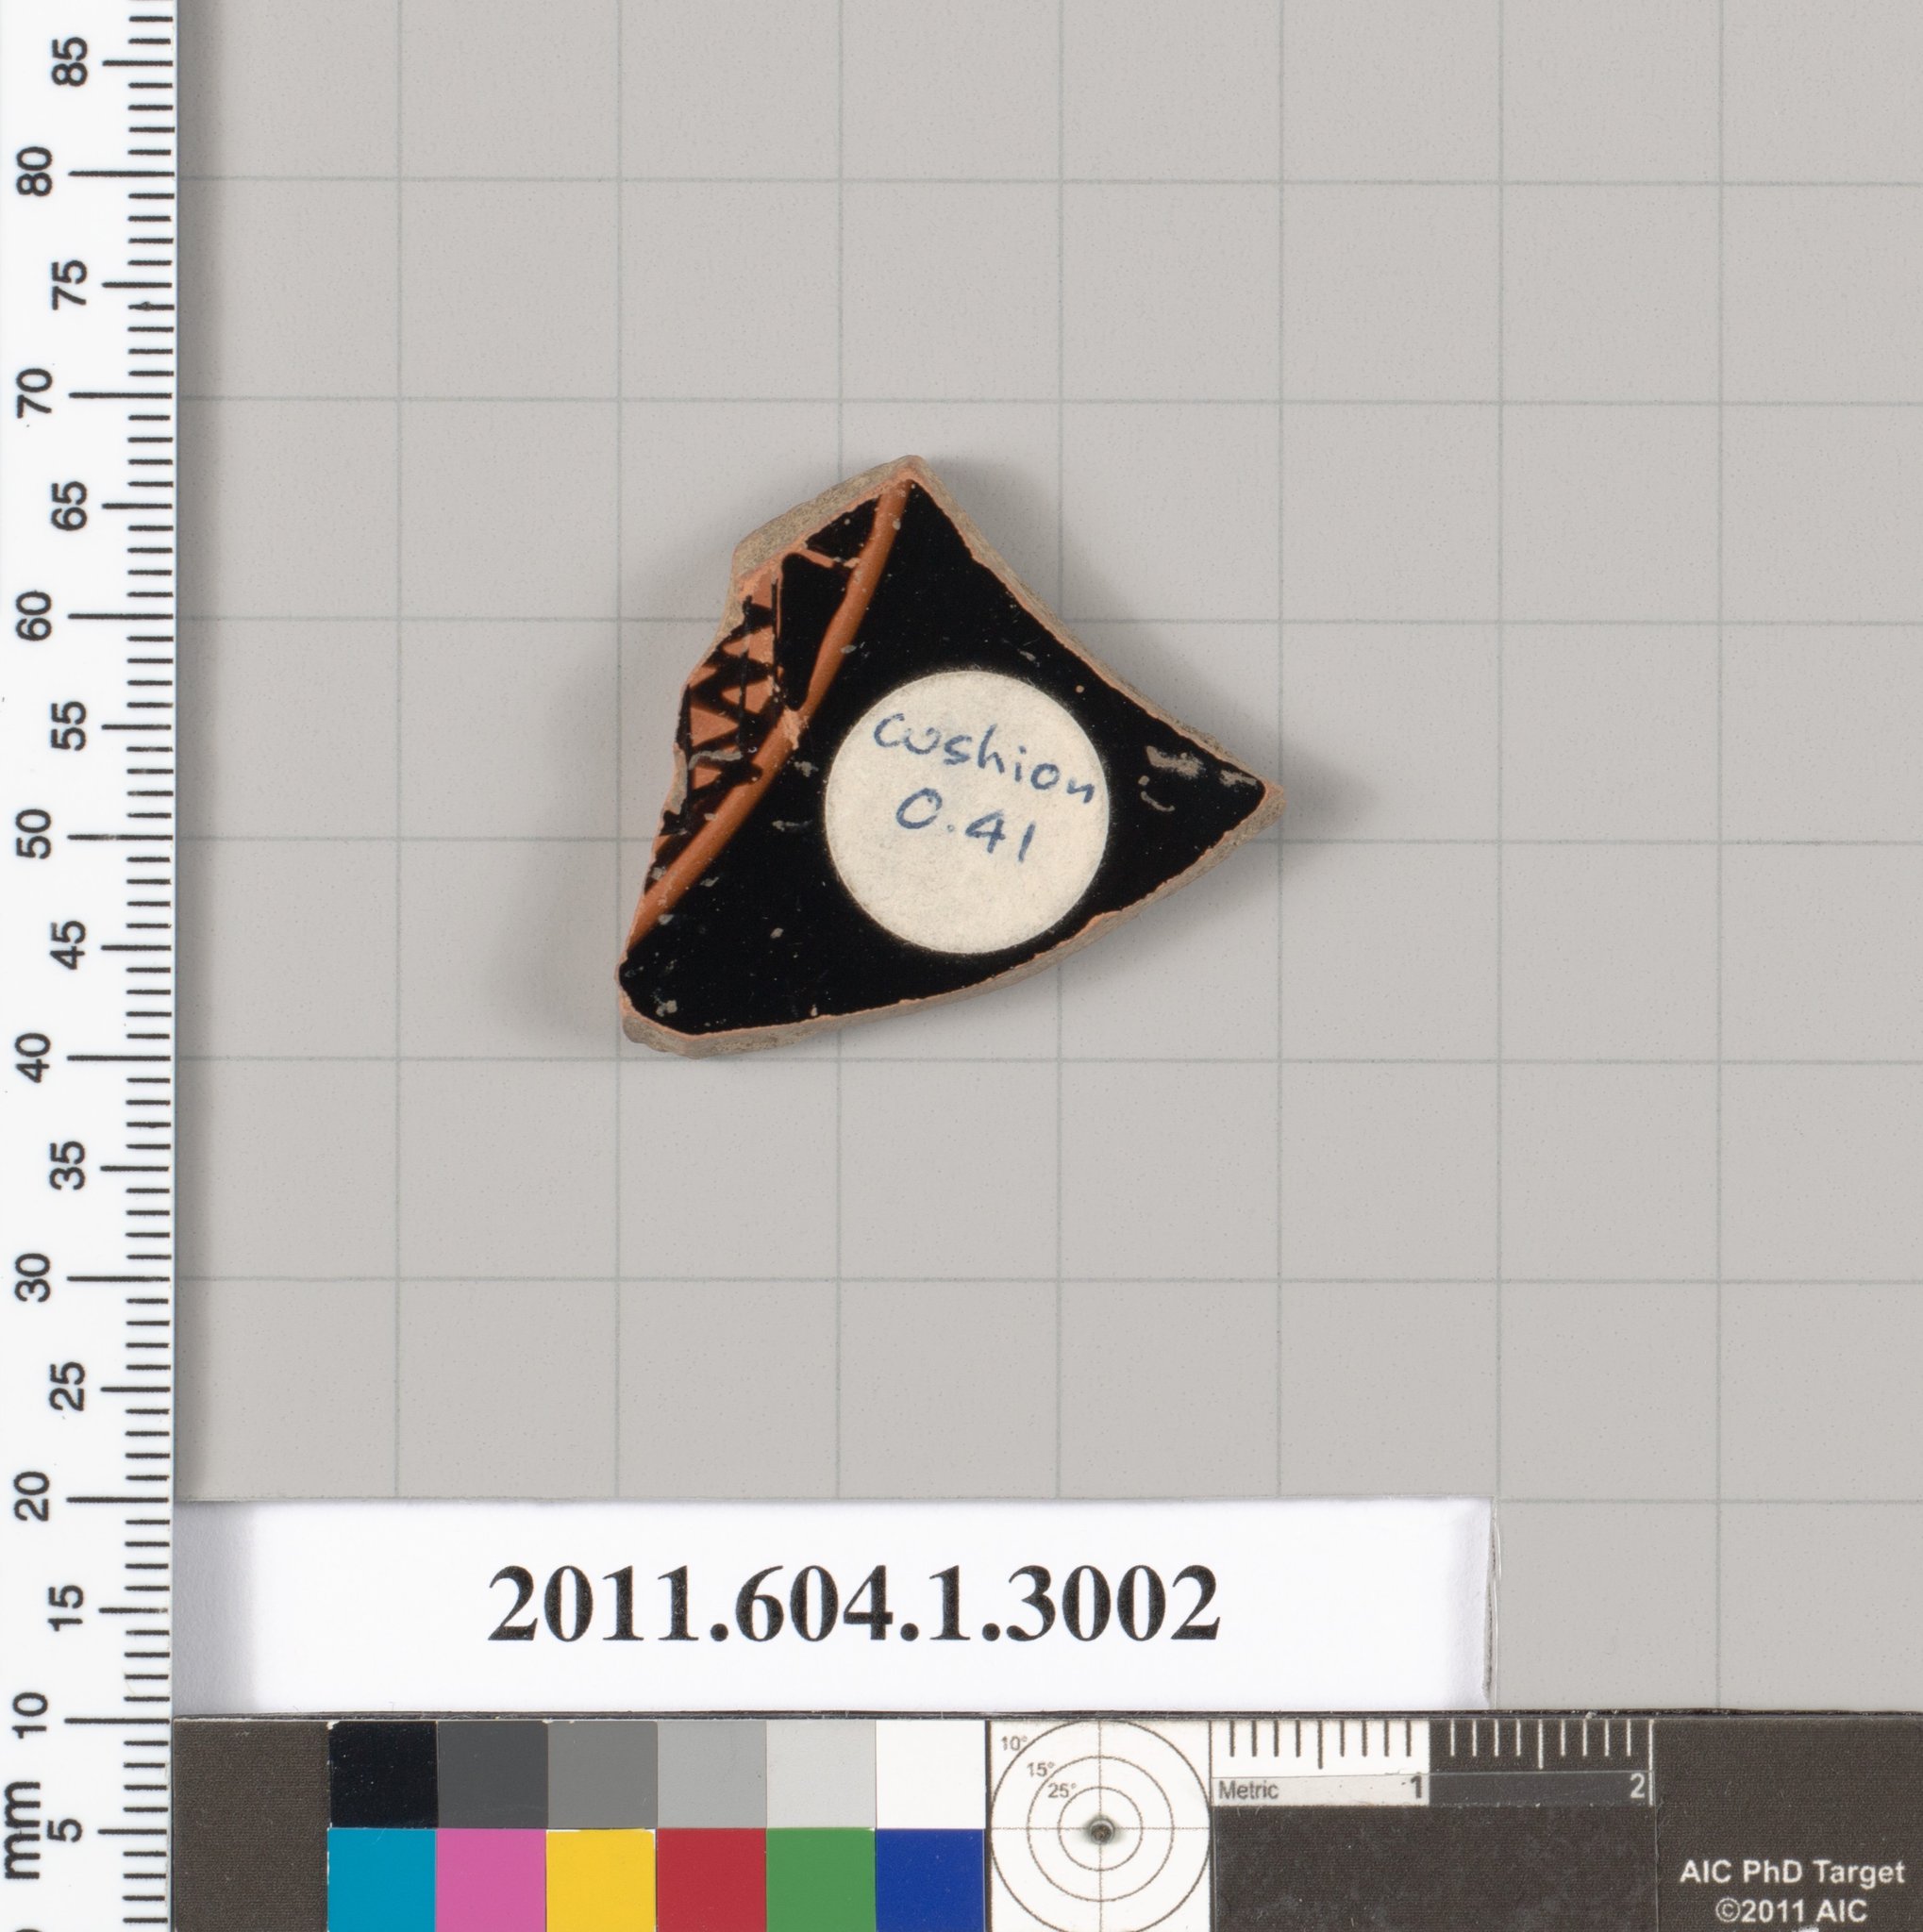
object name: kylix fragment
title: Terracotta fragment of a kylix (drinking cup)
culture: greek, attic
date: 500-480 BCE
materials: terracotta